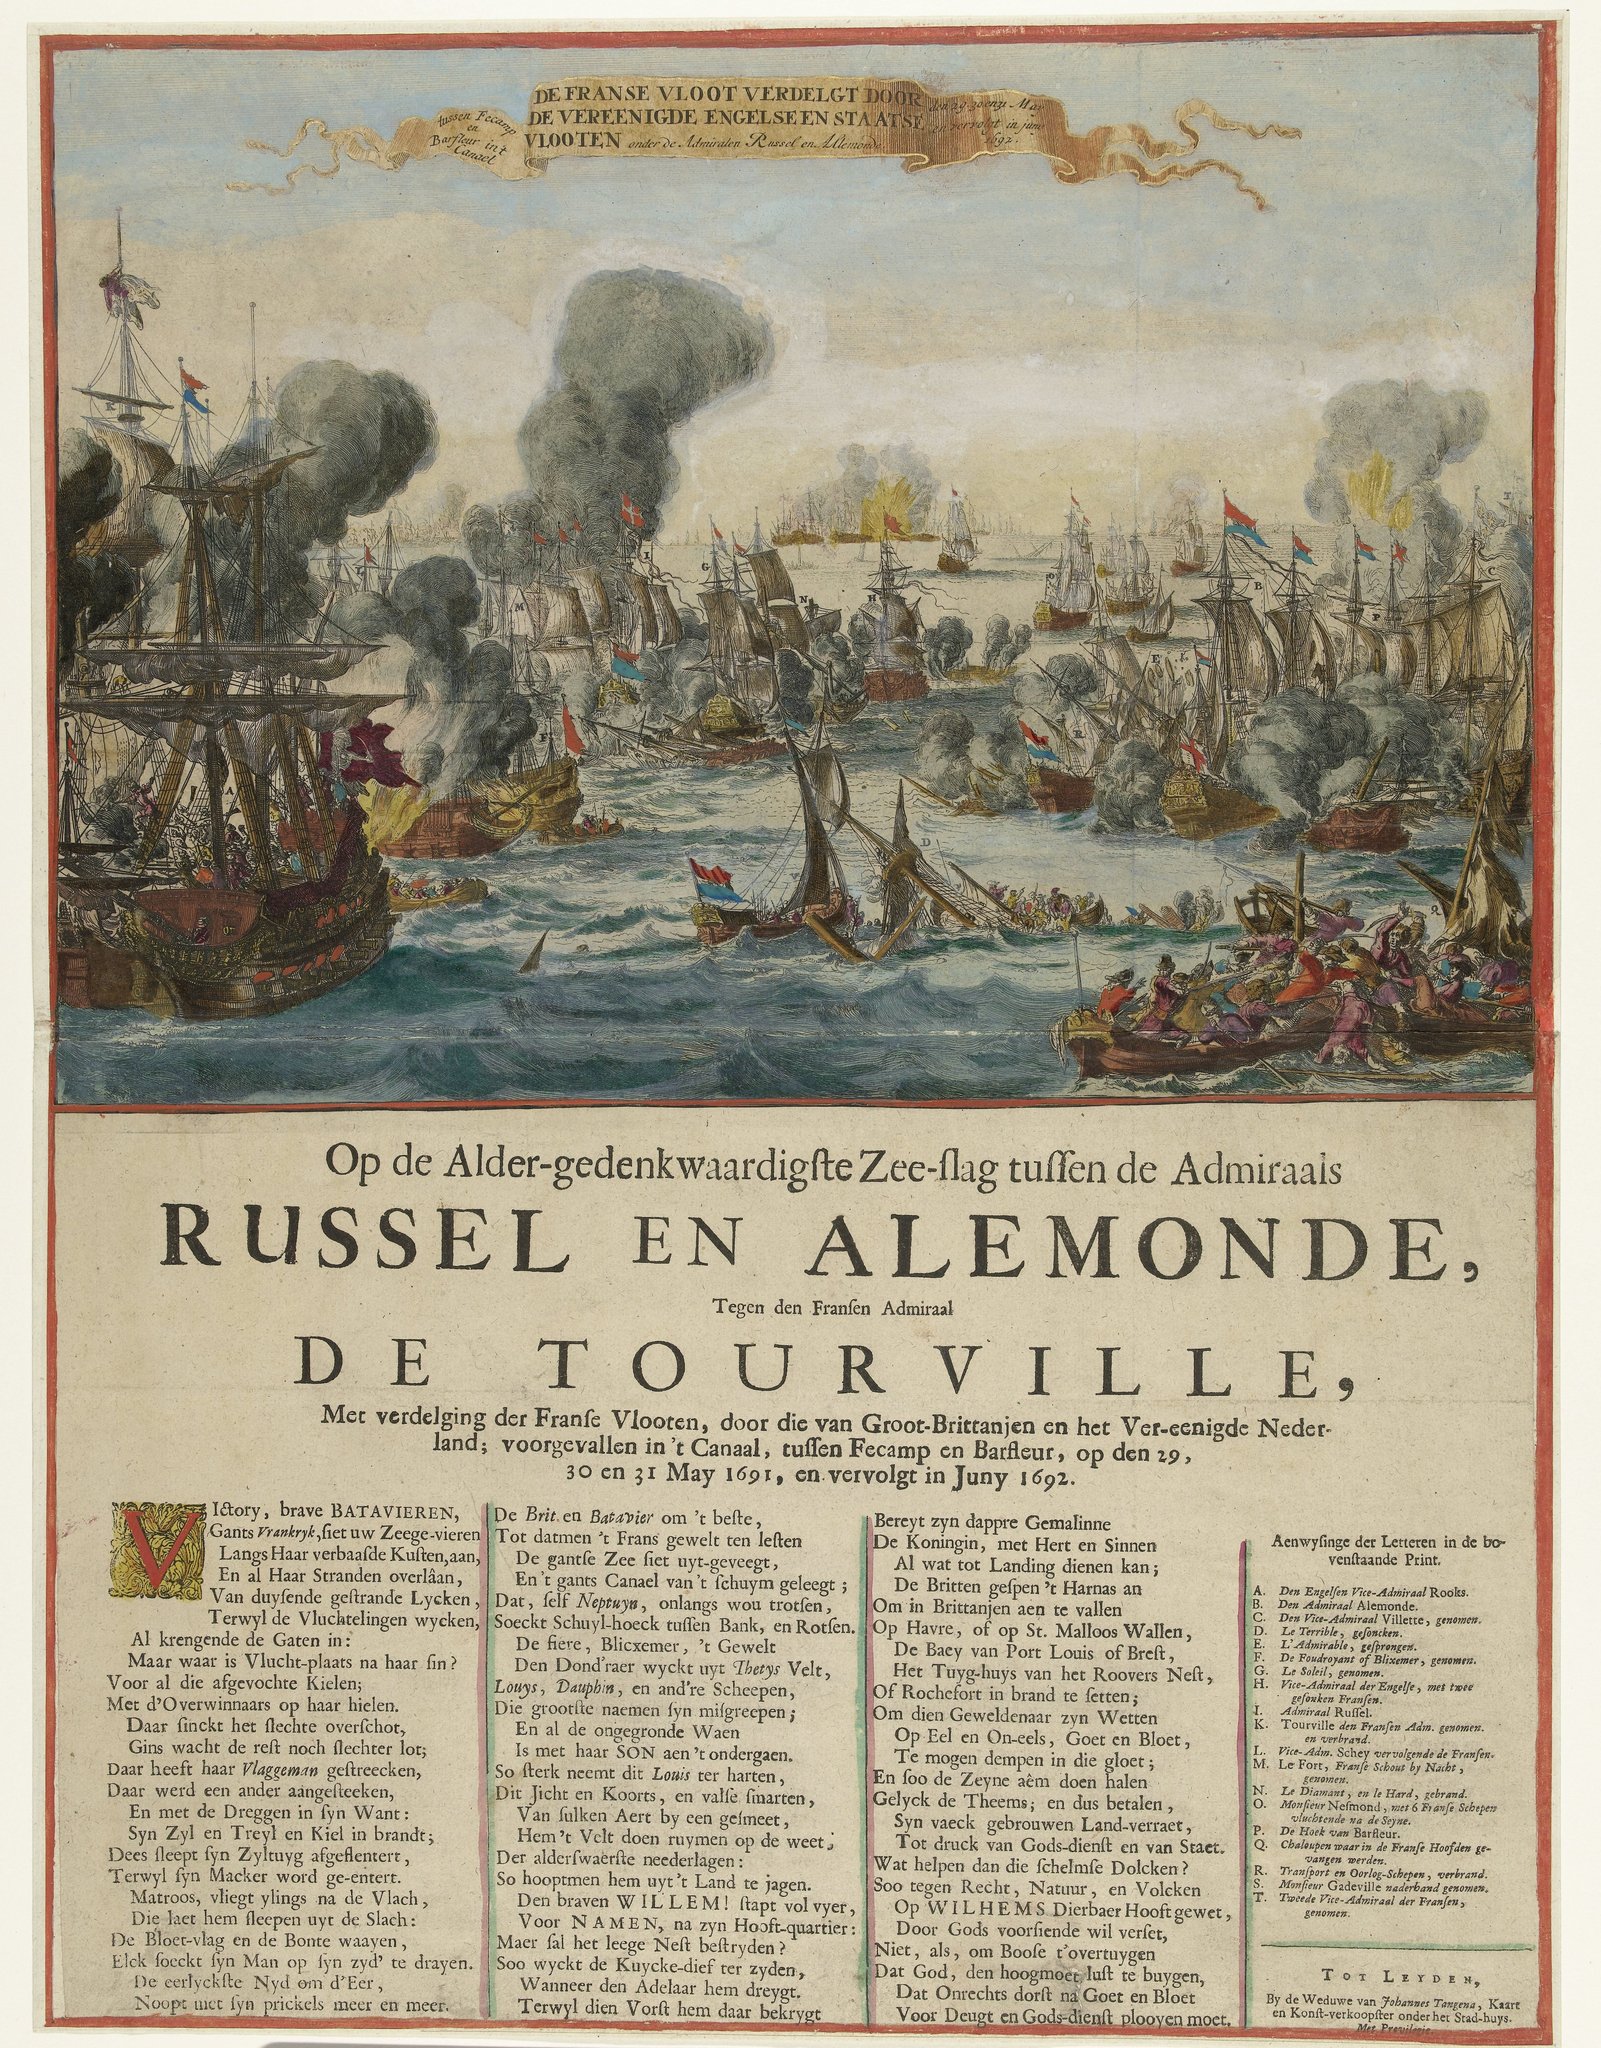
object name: print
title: De Franse vloot verdelgt door de vereenigde Engelse en Staatse vlooten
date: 1692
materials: paper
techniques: etching, hand coloring, letterpress printing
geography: northern netherlands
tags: paris, battle (+ naval force)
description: Zeeslag bij Kaap la Hogue waarbij de Fransen onder admiraal de Tourville werden verslagen door de gecombineerde vloot van Engeland en Holland onder de admiralen Russel en Almonde, 29 mei t/m 3 juni 1692. Onder de plaat een vers in 3 kolommen en de legenda A-T.